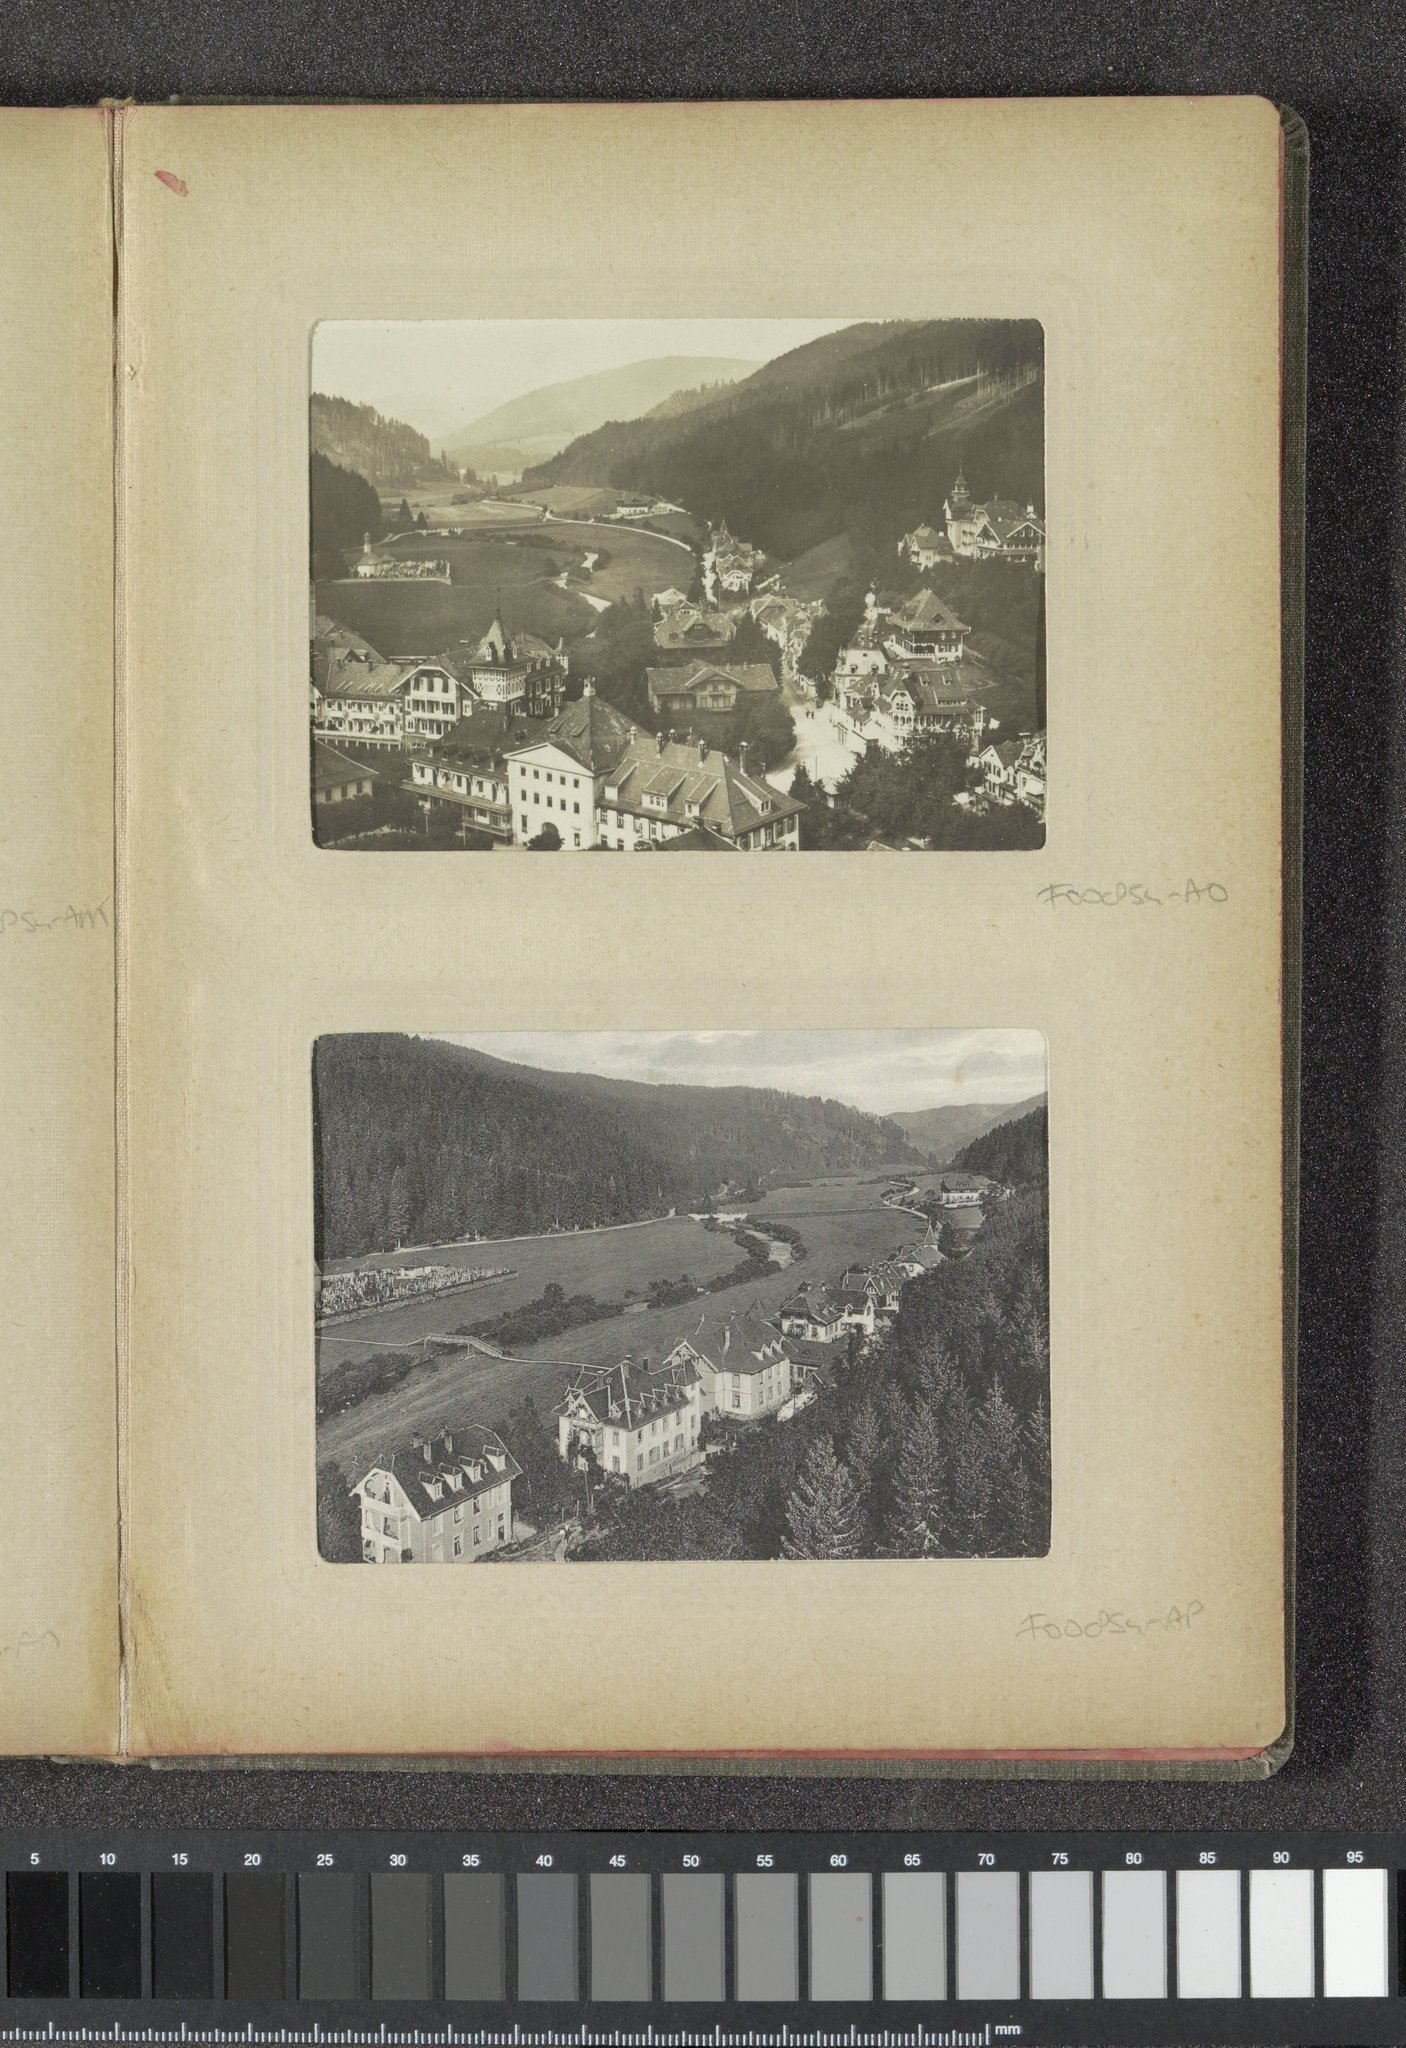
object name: ansichtkaart, prentbriefkaart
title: St. Blasien. Schwarzwald.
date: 1890-1910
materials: cardboard, paper, photographic support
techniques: daylight paper print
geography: st. blasien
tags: prospect of village, silhouette of village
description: Onderdeel van Fotoalbum van Carl Heinrich Fliegenschmidt, gevangenisdirecteur te Oslebshausen.